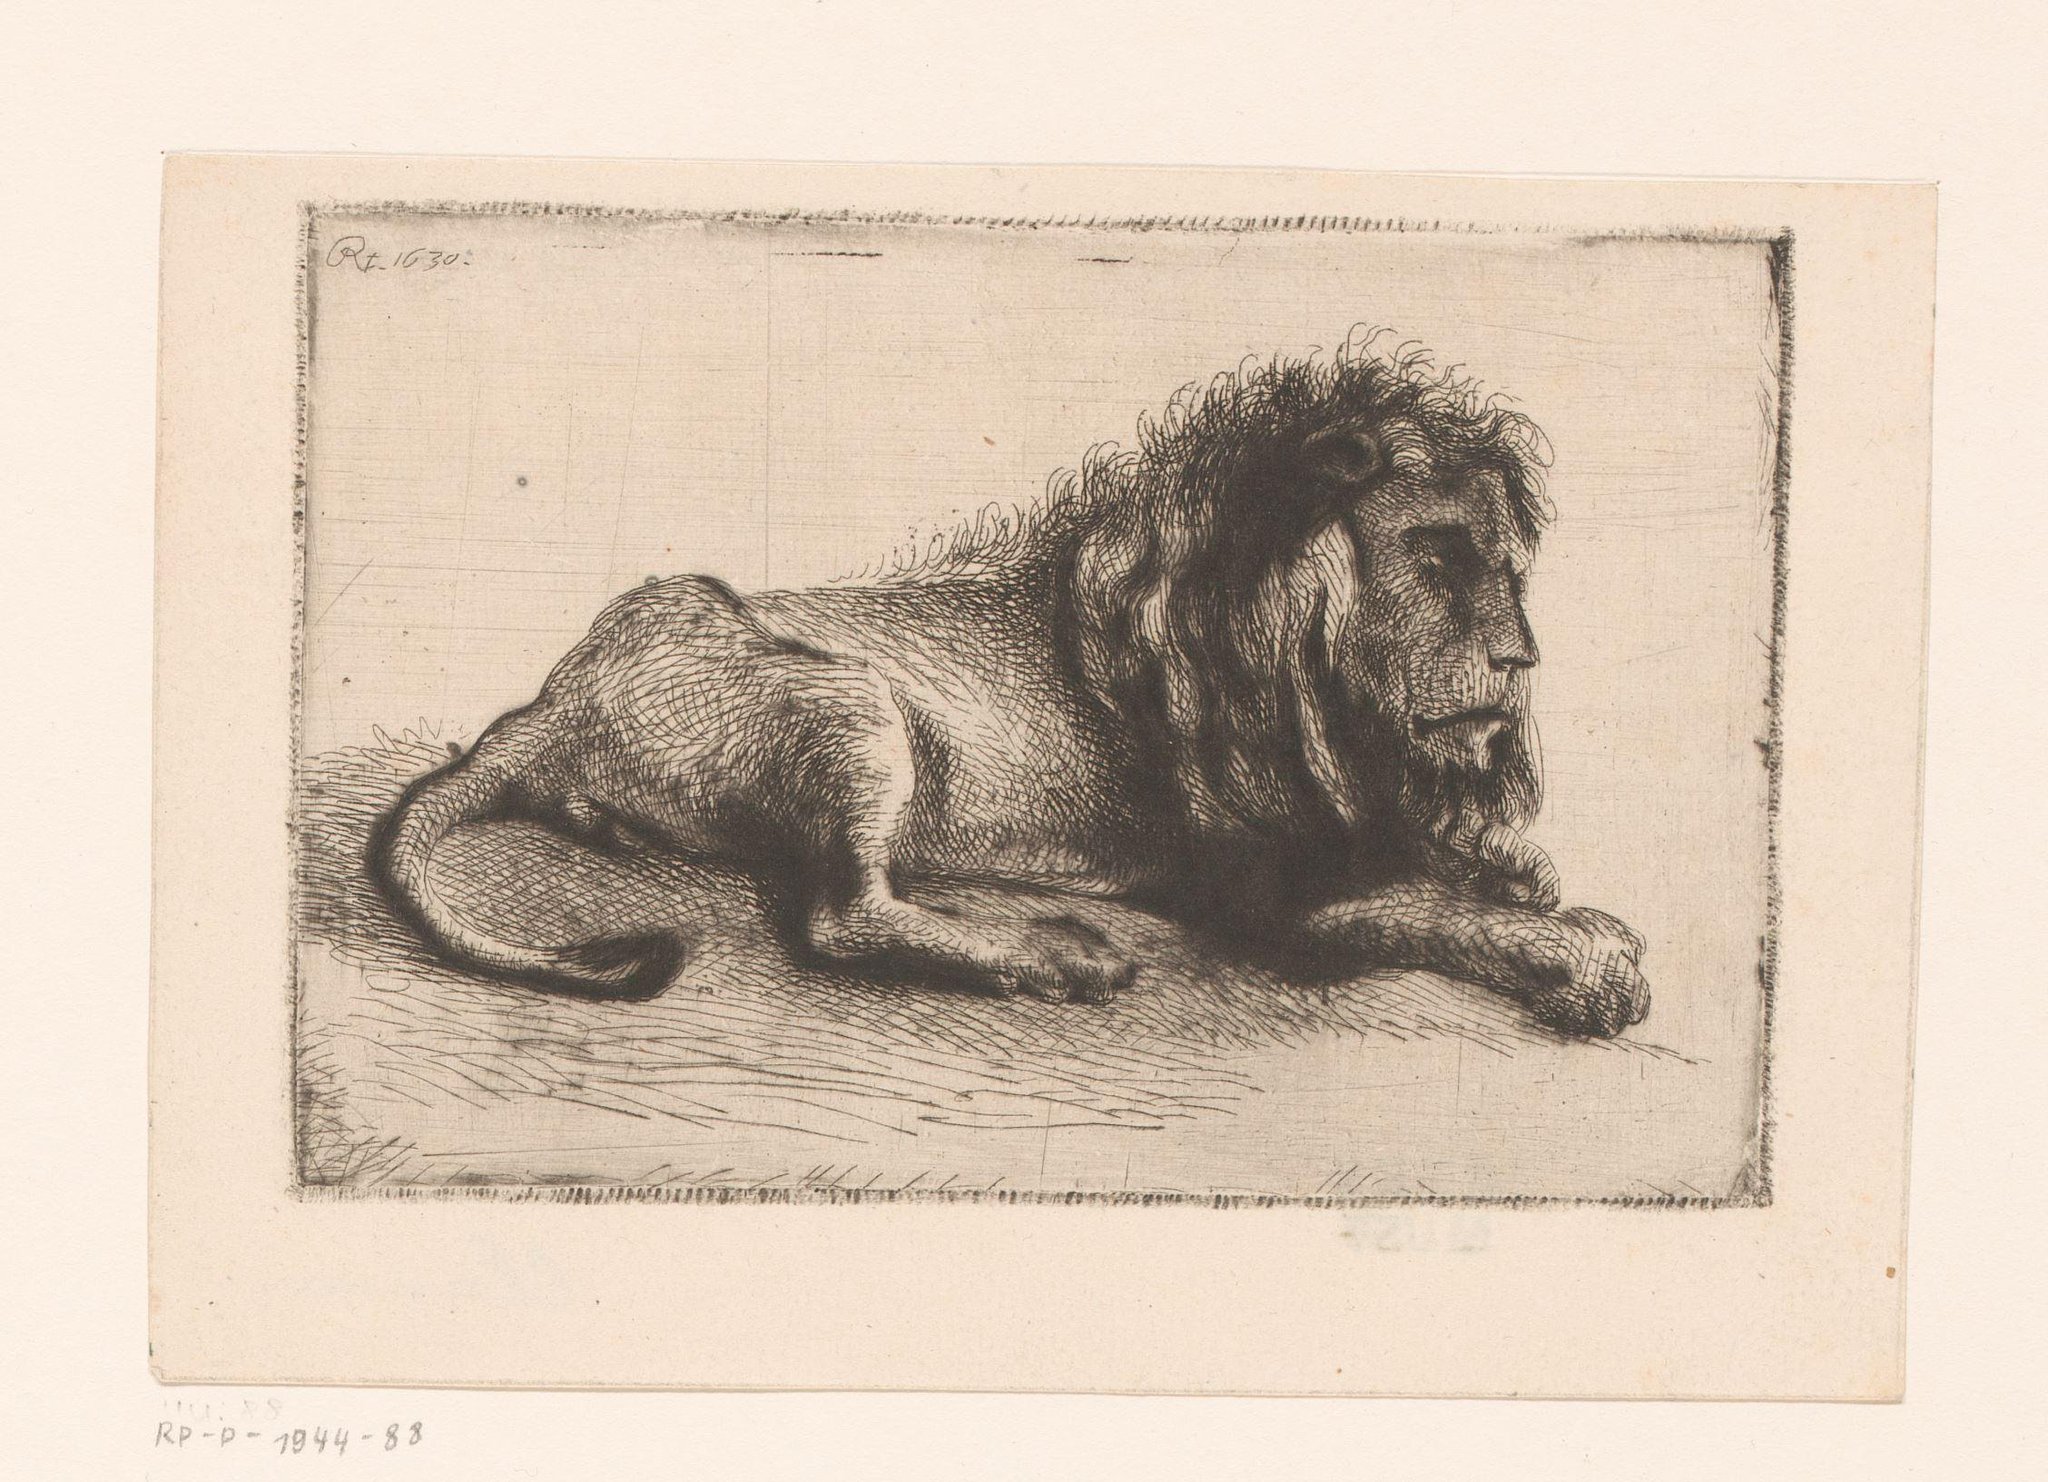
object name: print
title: Slapende leeuw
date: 1805-1844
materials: paper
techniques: drypoint, engraving, etching, intaglio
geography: france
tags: beasts of prey, predatory animals: lion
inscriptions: collector's mark: Lugt 2165